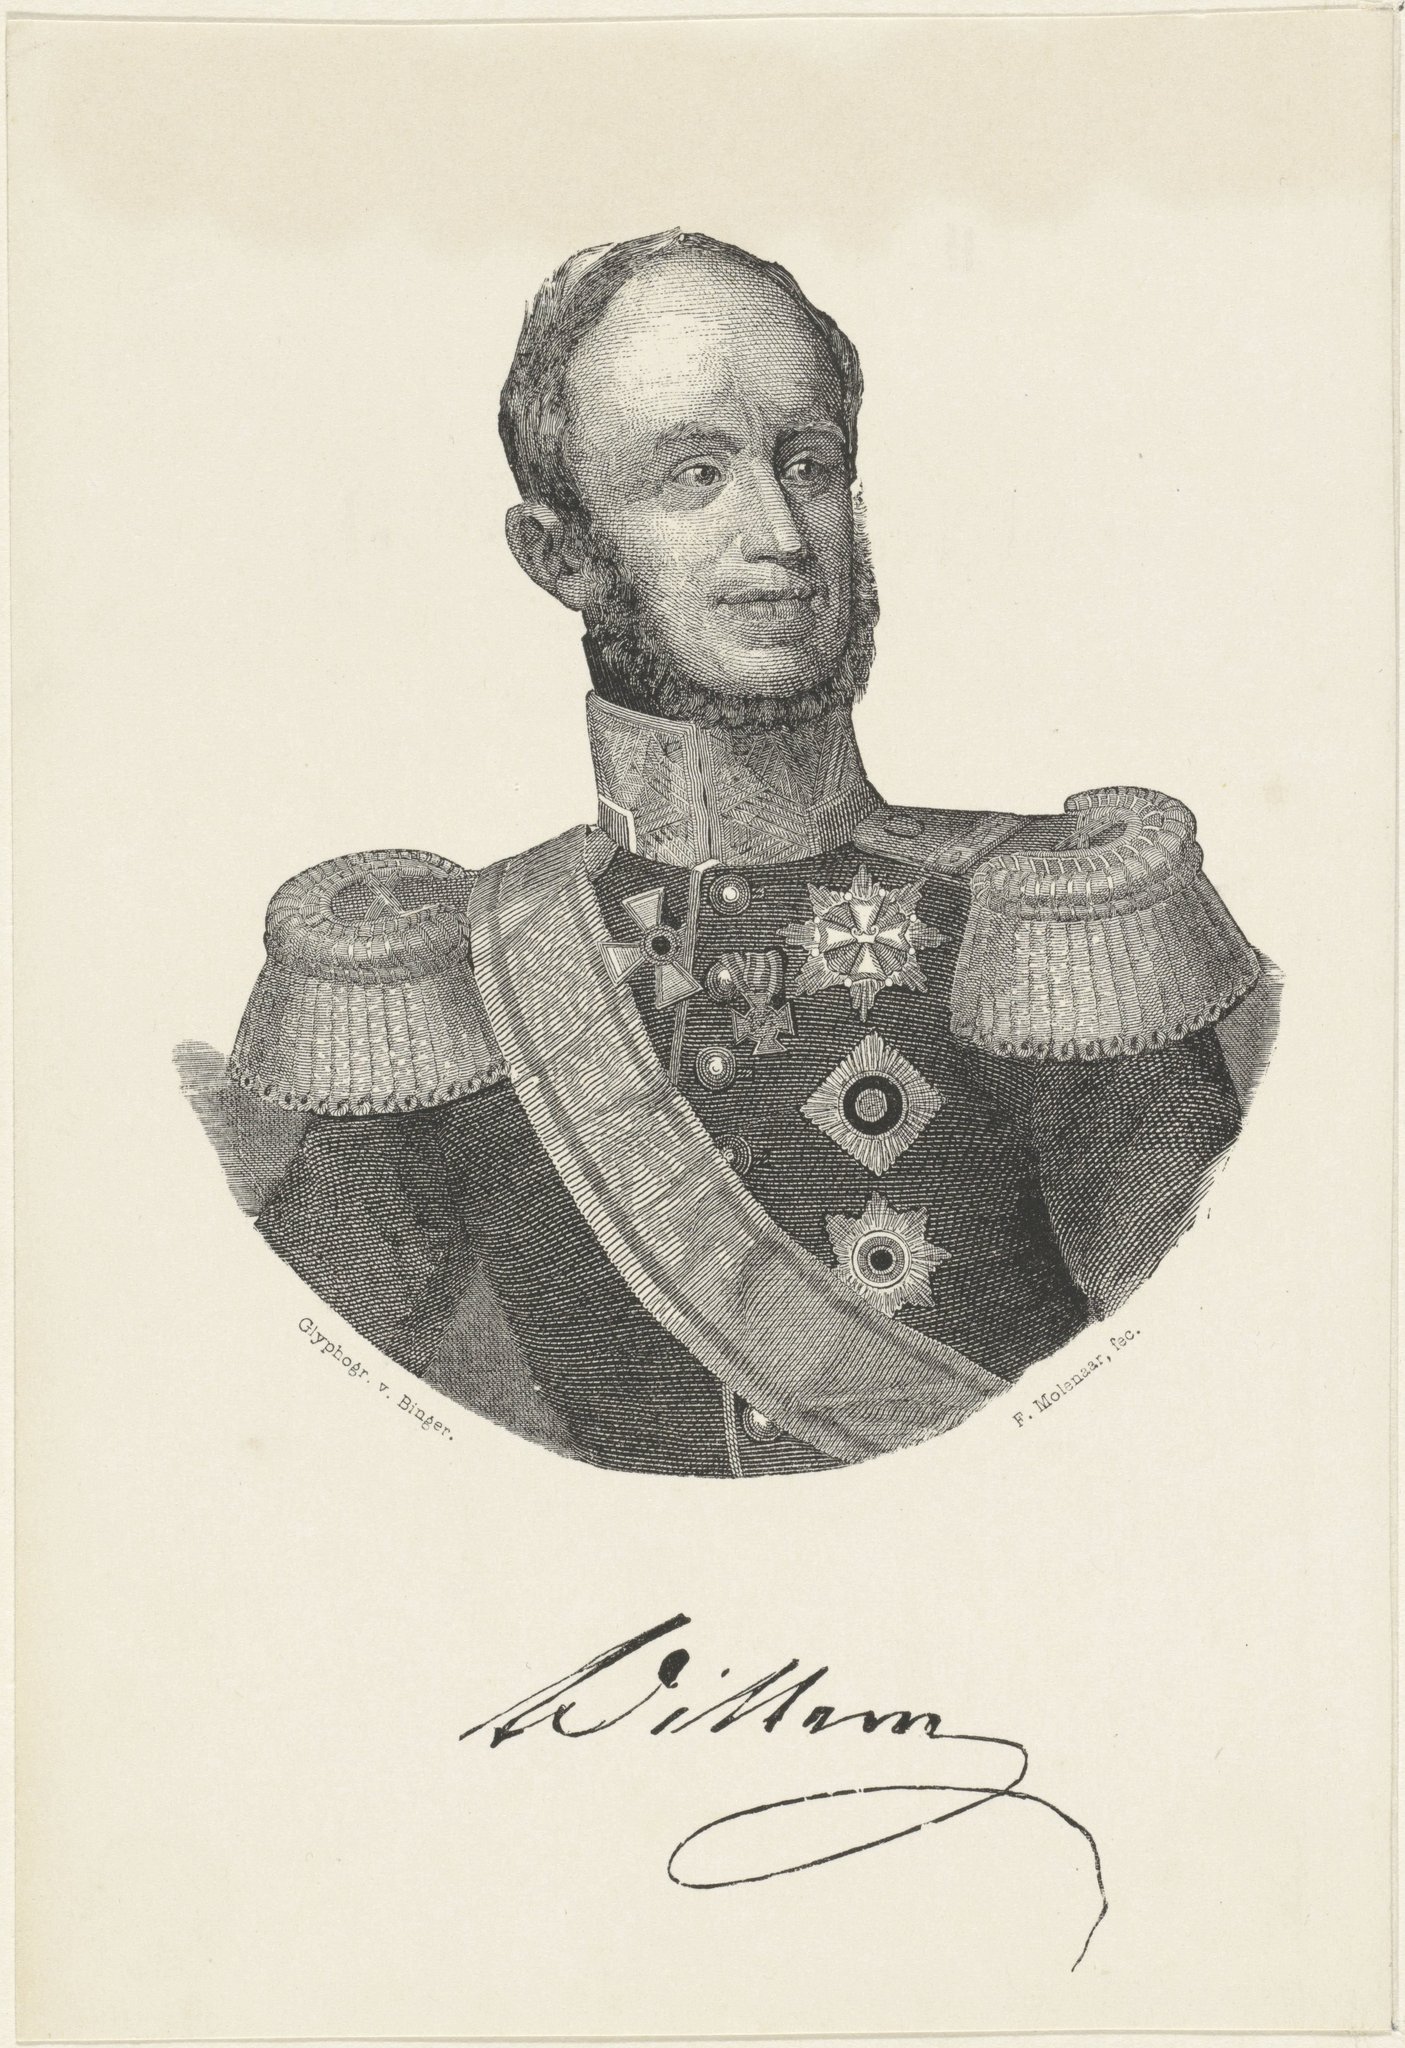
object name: print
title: Portret van Willem II, koning der Nederlanden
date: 1839-1853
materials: paper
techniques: gypsography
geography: amsterdam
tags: the hague, william ii of the netherlands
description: De hier vermelde titel verwijst naar de hoogst verkregen titel van de geportretteerde, niet per se naar de titel die de geportretteerde op deze voorstelling draagt.